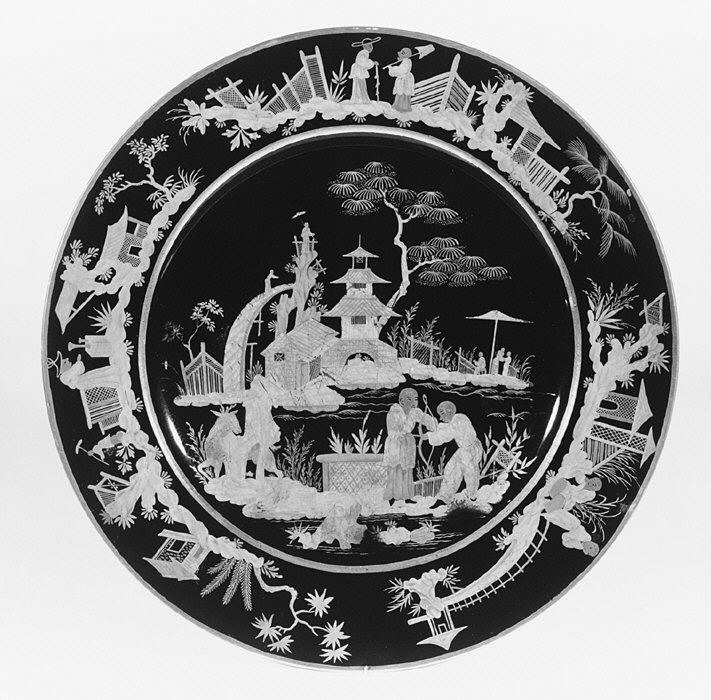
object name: plate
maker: sèvres manufactory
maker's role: manufactory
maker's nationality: french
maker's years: 1740-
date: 1791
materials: hard paste porcelain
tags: animals,chinoiserie,buildings,men